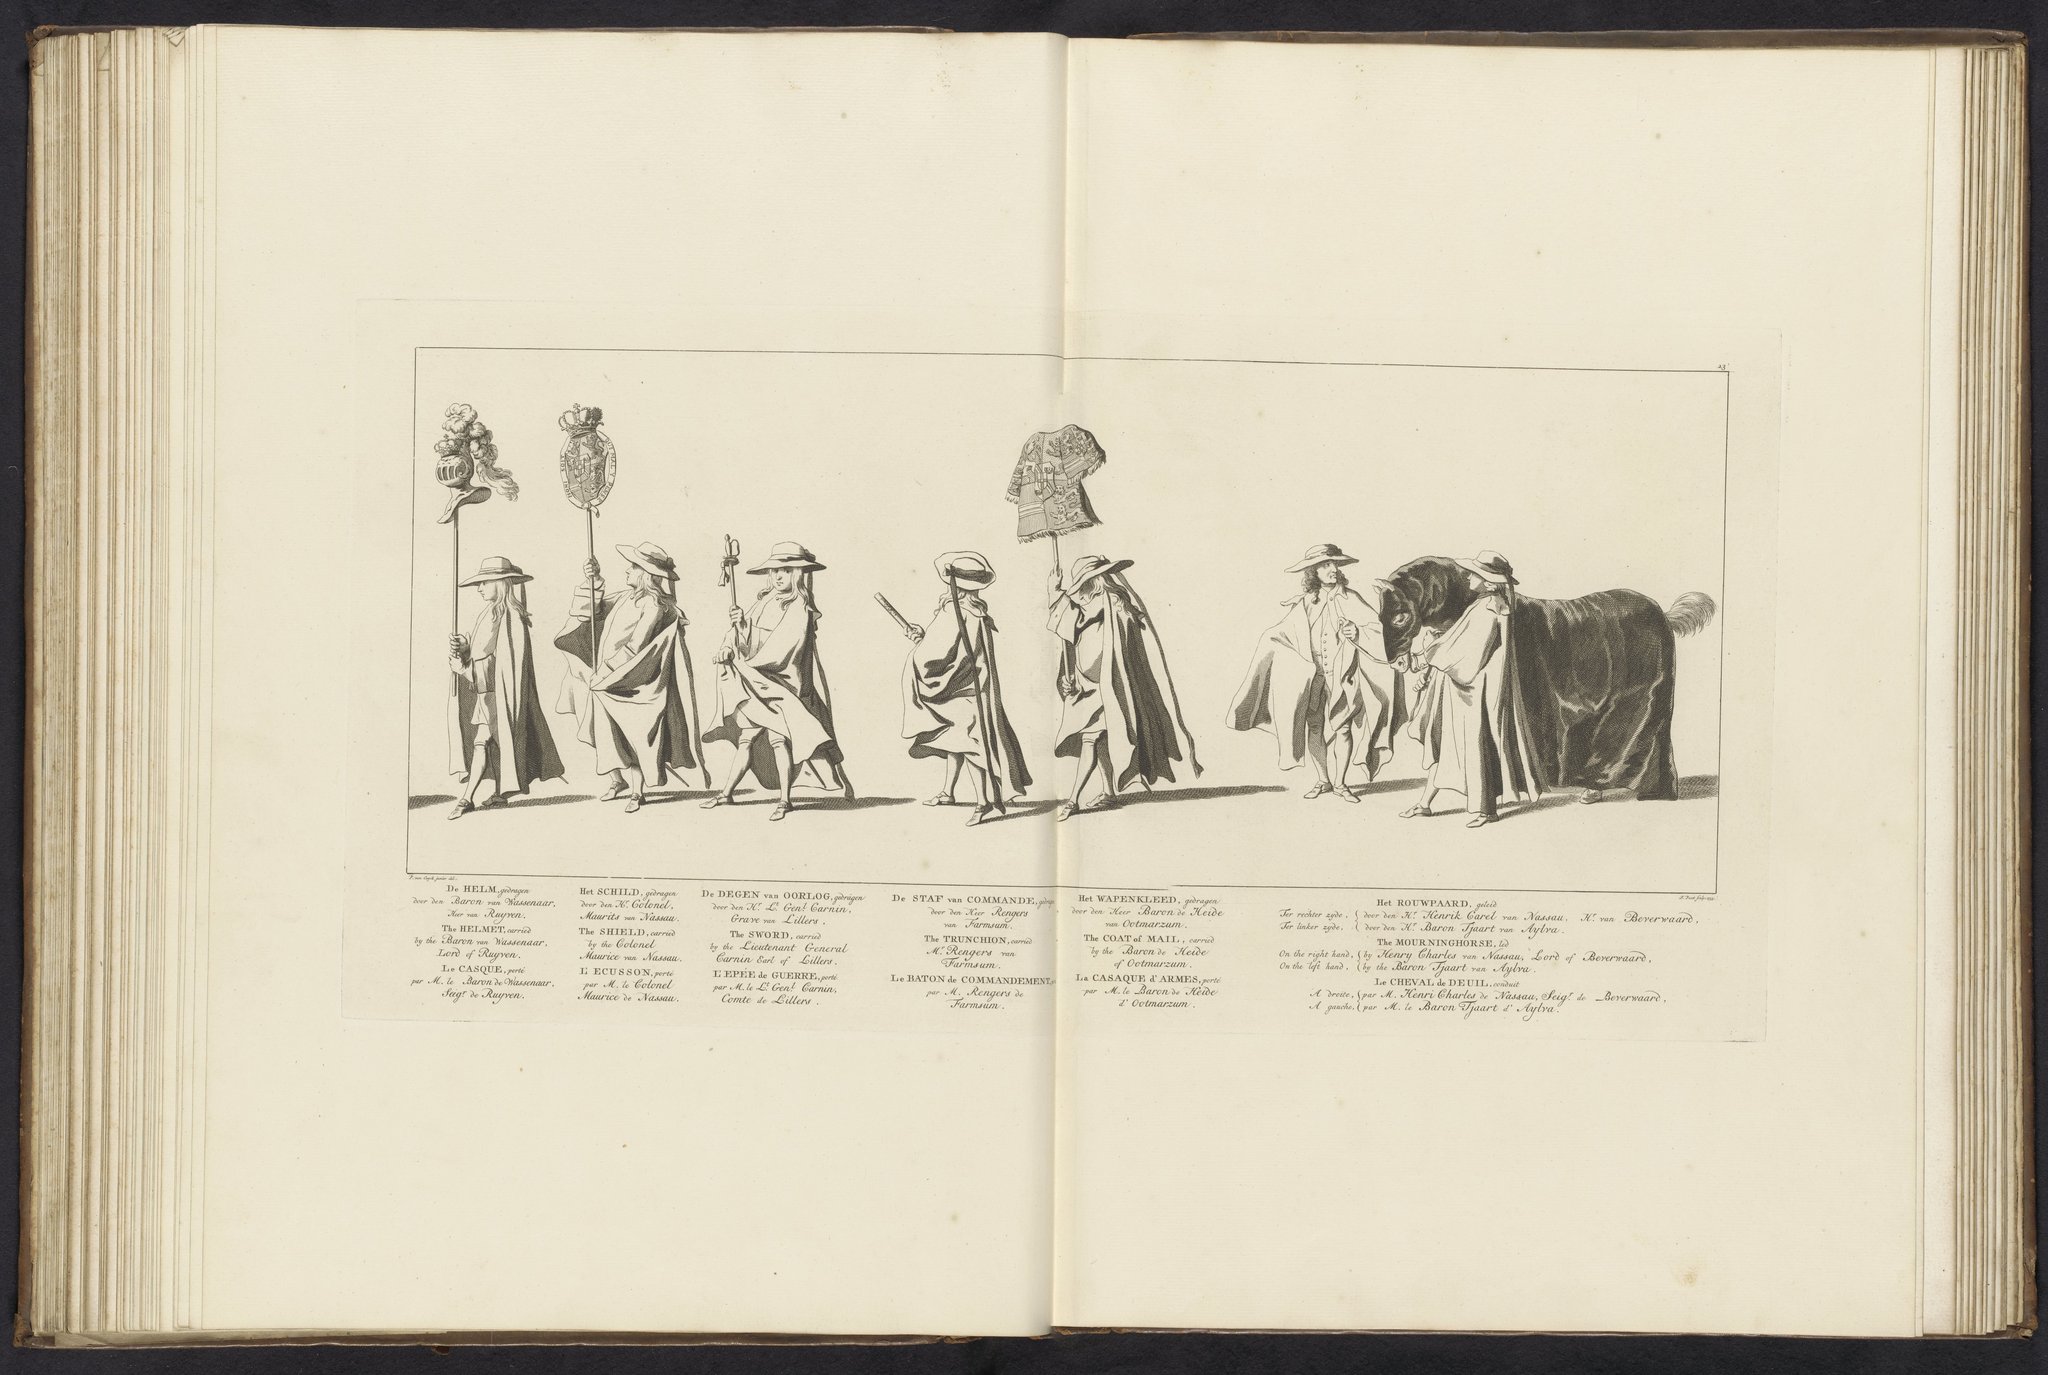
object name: print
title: De Helm / het Schild / De Degen van Oorlog / De Staf van Commande / Het Wapenkleed / Het Rouwpaard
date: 1753-1755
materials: paper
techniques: engraving, etching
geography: northern netherlands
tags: the hague, willem iv (prins van oranje-nassau), cortege, funeral procession, insignia and symbols of sovereignty (crown, diadem, sceptre, orb, seal, standard, cloak, pectoral), delft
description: Dragers met stadhouderlijke insignia en een rouwpaard. In de marge het onderschrift in Nederlands, Frans en Engels. Onderdeel van een serie van 41 platen van de begrafenisstoet van stadhouder Willem IV te Delft op 4 februari 1752. Genummerd rechtsboven: 23. In de gebonden uitgave van 1755.